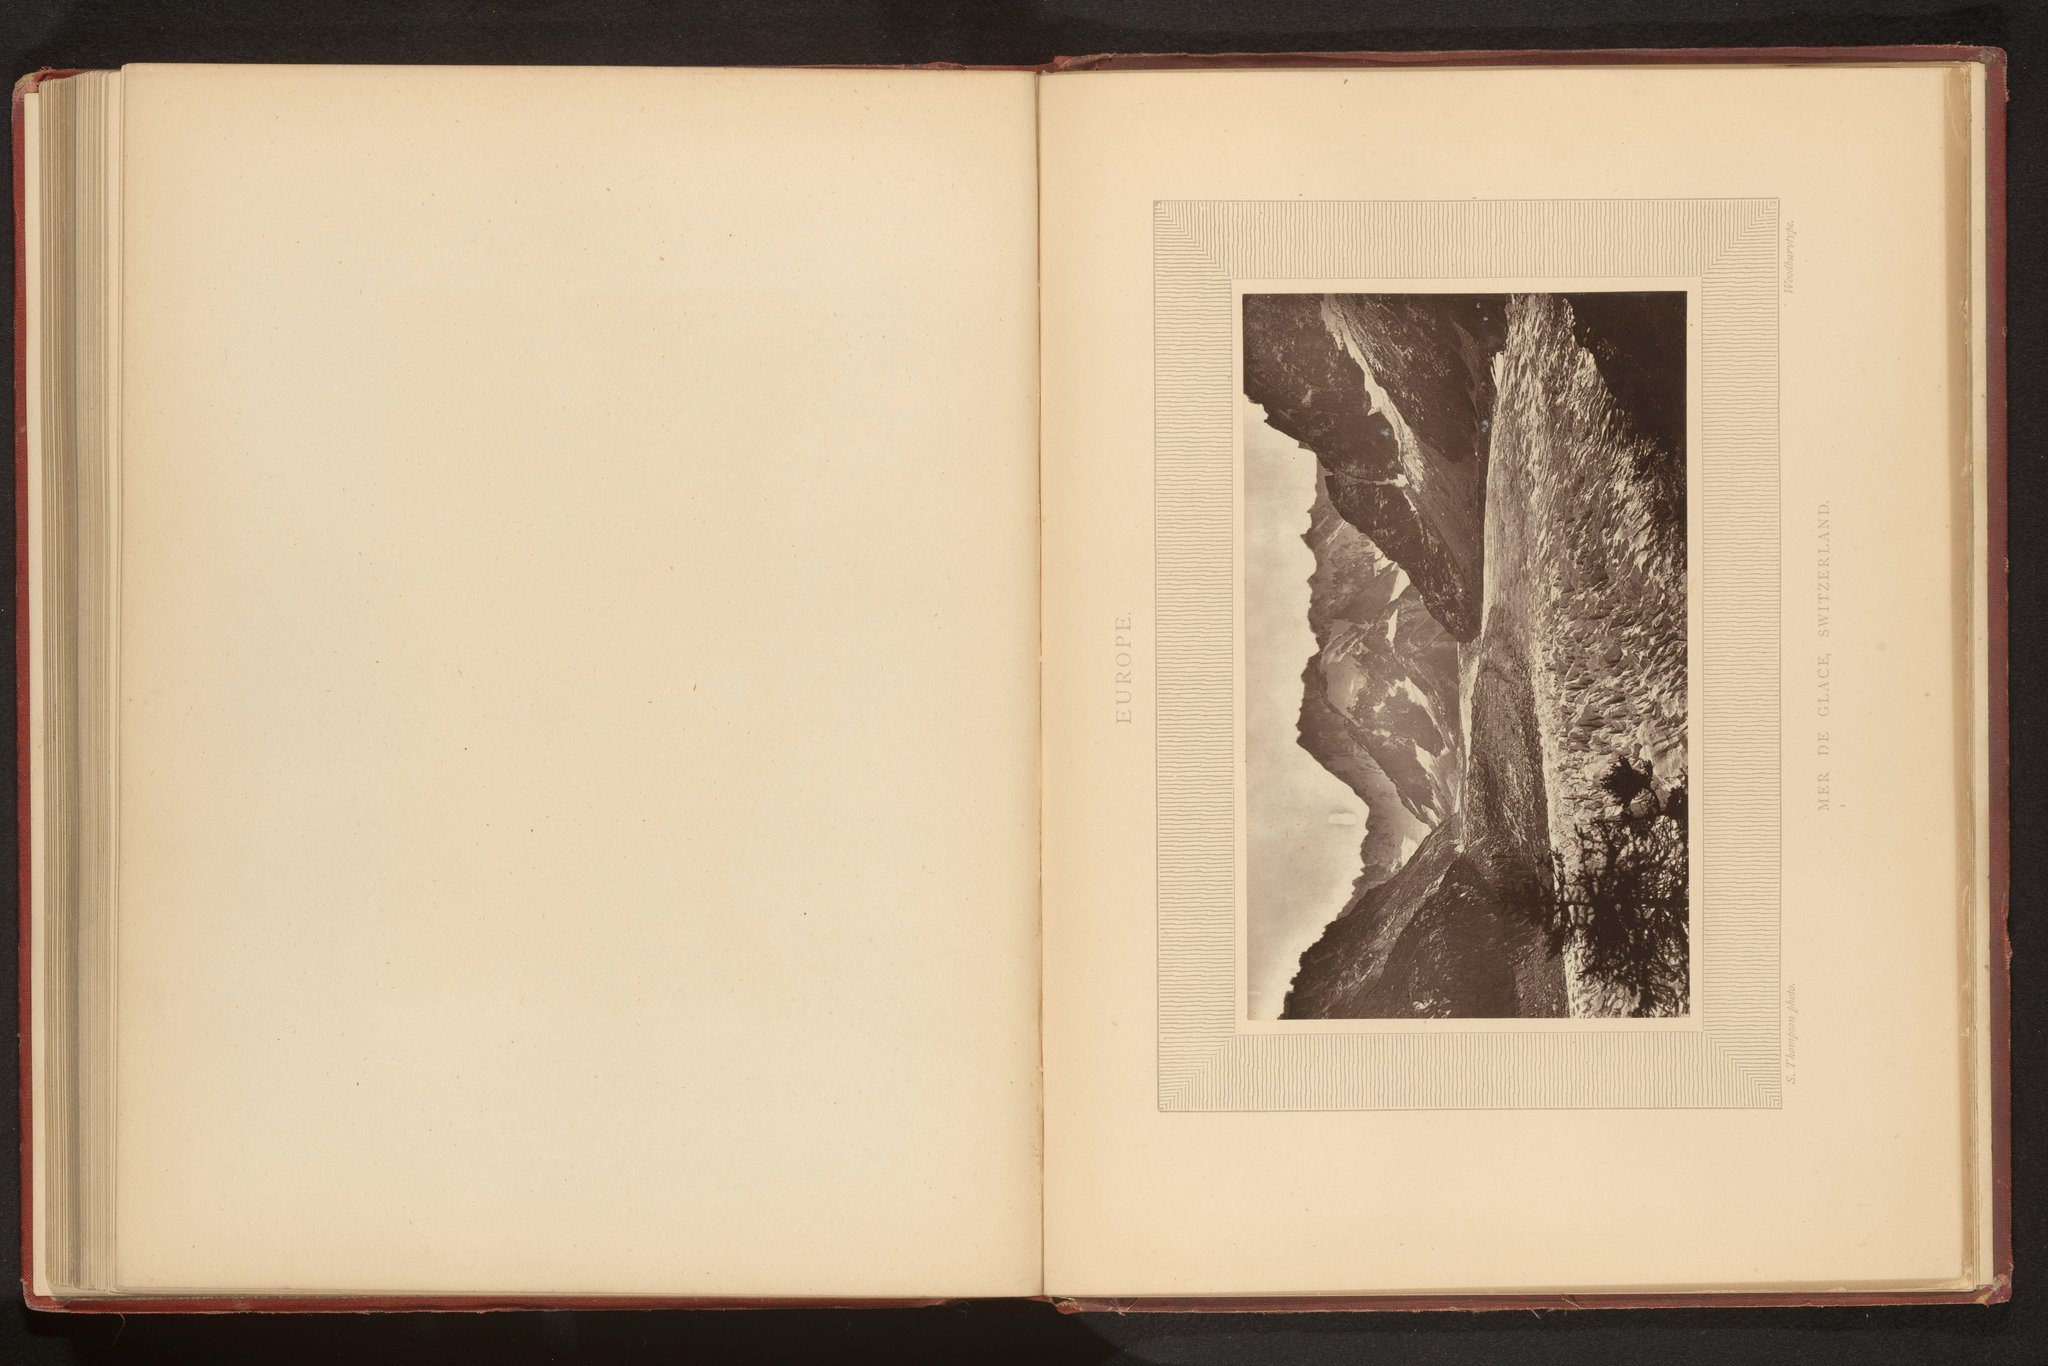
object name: page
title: Gezicht op de Mer de Glace te Zwitserland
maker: stephen thompson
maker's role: fotograaf, schrijver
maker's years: 1831-1893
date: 1870-1875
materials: cardboard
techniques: woodburytype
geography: gibraltar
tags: glacier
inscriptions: inscription: ‘Europe’